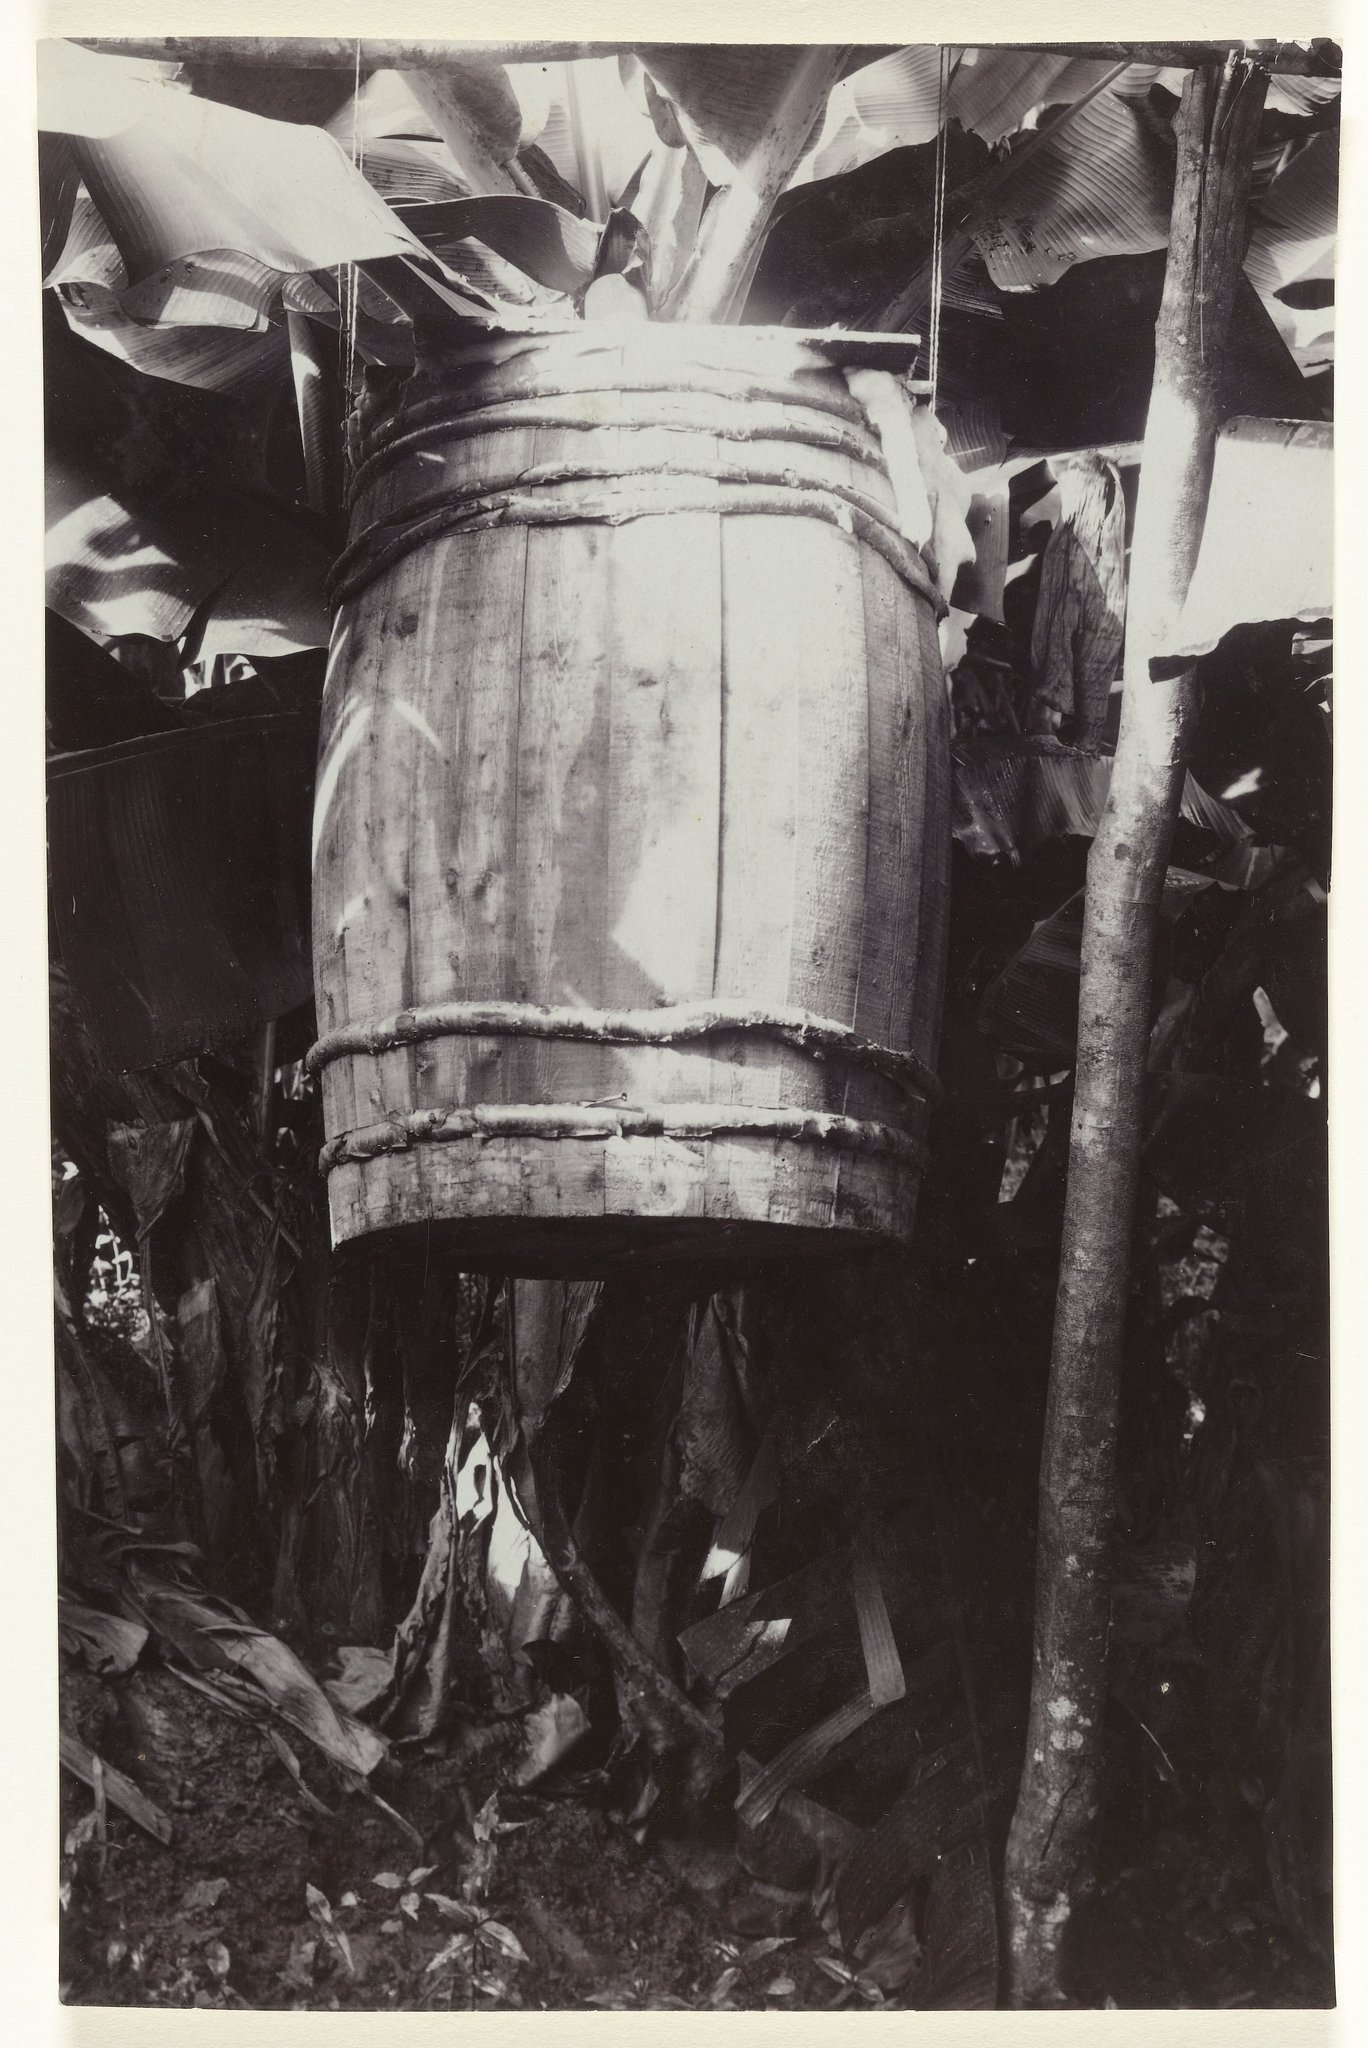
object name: photograph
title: Ongediertebestrijding op bananenbomen op plantage Accaribo te Suriname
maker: theodoor brouwers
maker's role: amateurfotograaf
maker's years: 1874-1932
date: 1916-1930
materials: photographic support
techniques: photography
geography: suriname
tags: amsterdam, theodoor brouwers, plantation, suriname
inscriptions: inscription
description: In de periode 1911-1932 woonde op plantage Accaribo in Suriname de familie Brouwers van wie de foto's afkomstig zijn. Rond 1910 vond Theodoor Brouwers werk op plantage Accaribo. In 1929 werd hij eigenaar van de plantage.